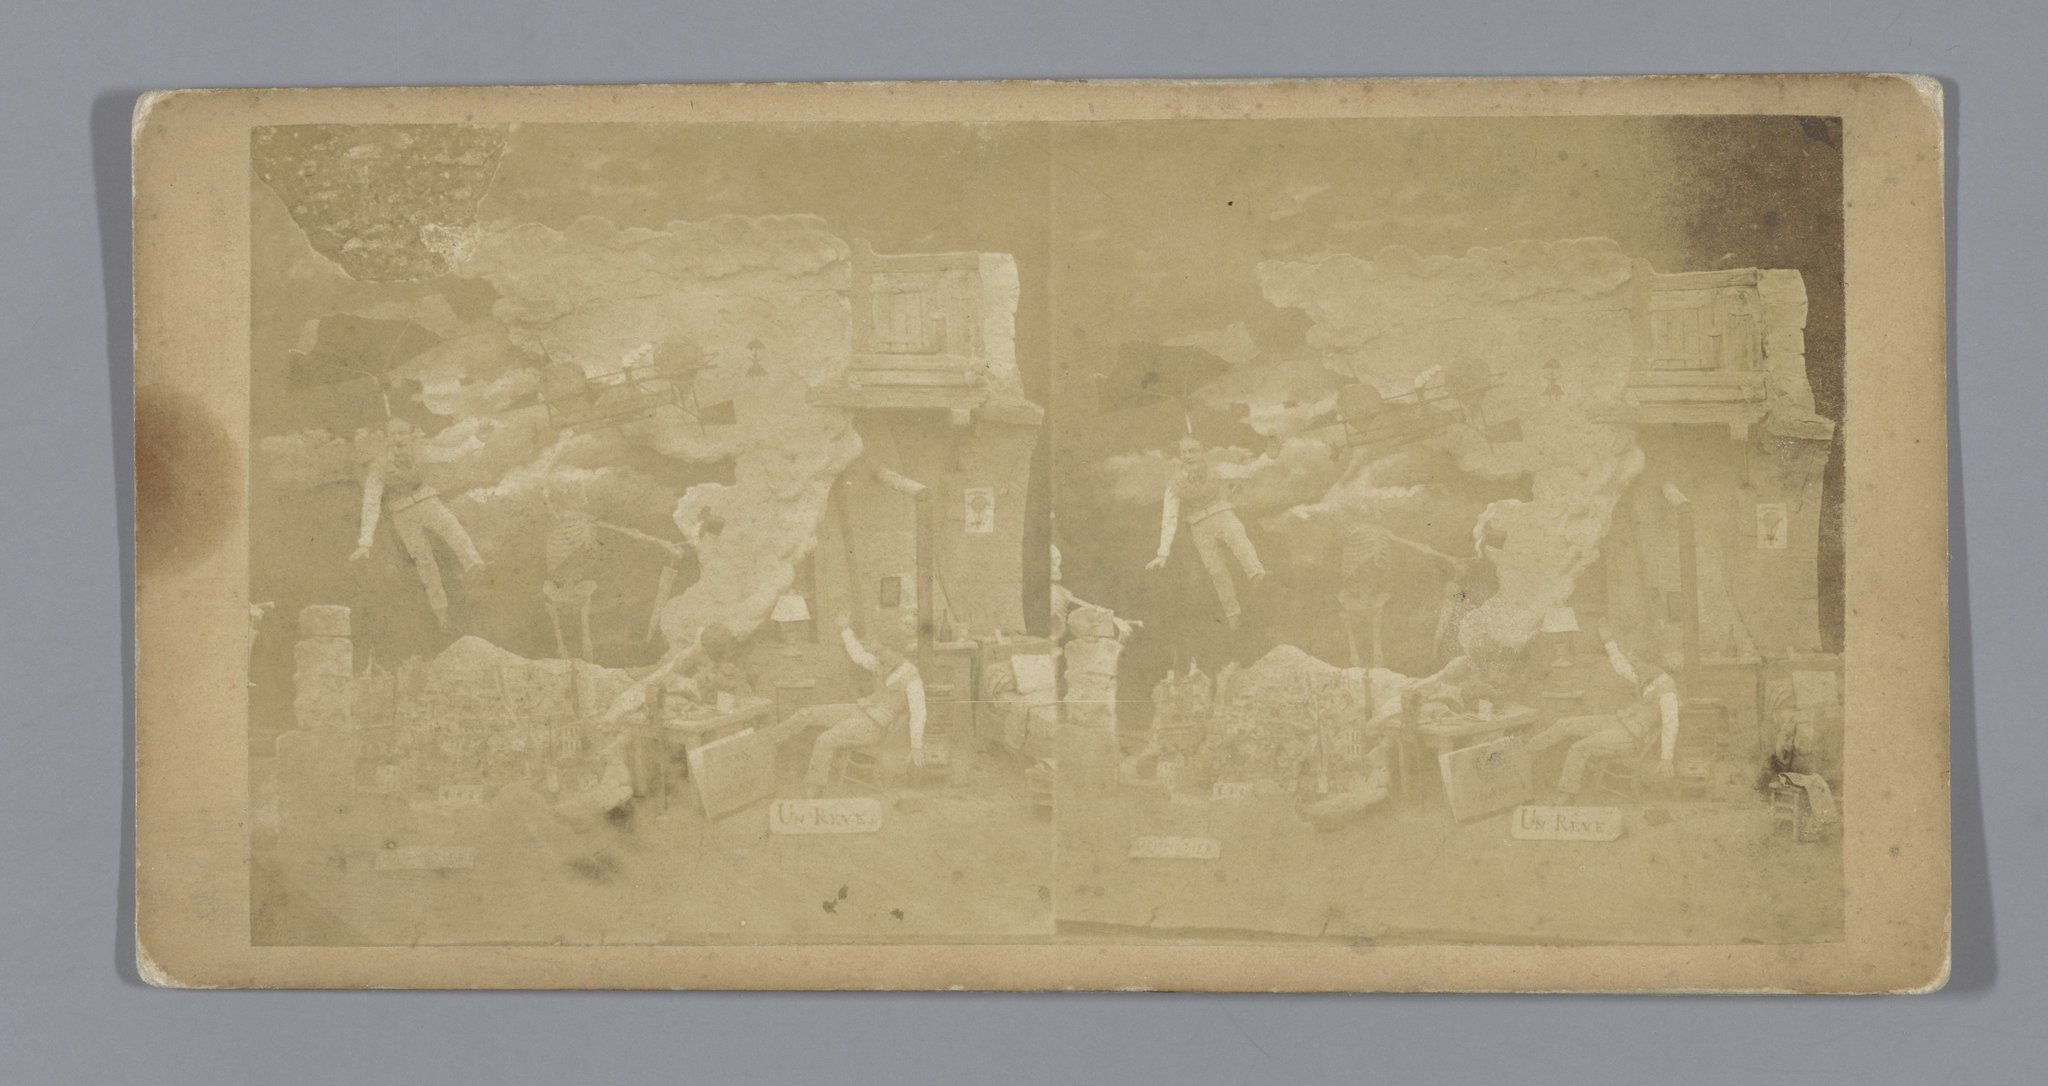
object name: stereograph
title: Enscenering van poppen in een decor, voorstellend een droom met vallende mannen, een ruïne en een skelet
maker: Anonymous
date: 1850-1880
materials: cardboard, photographic support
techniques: albumen print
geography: europe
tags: dream, europe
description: Voor de enscenering staat de tekst: Un Reve.